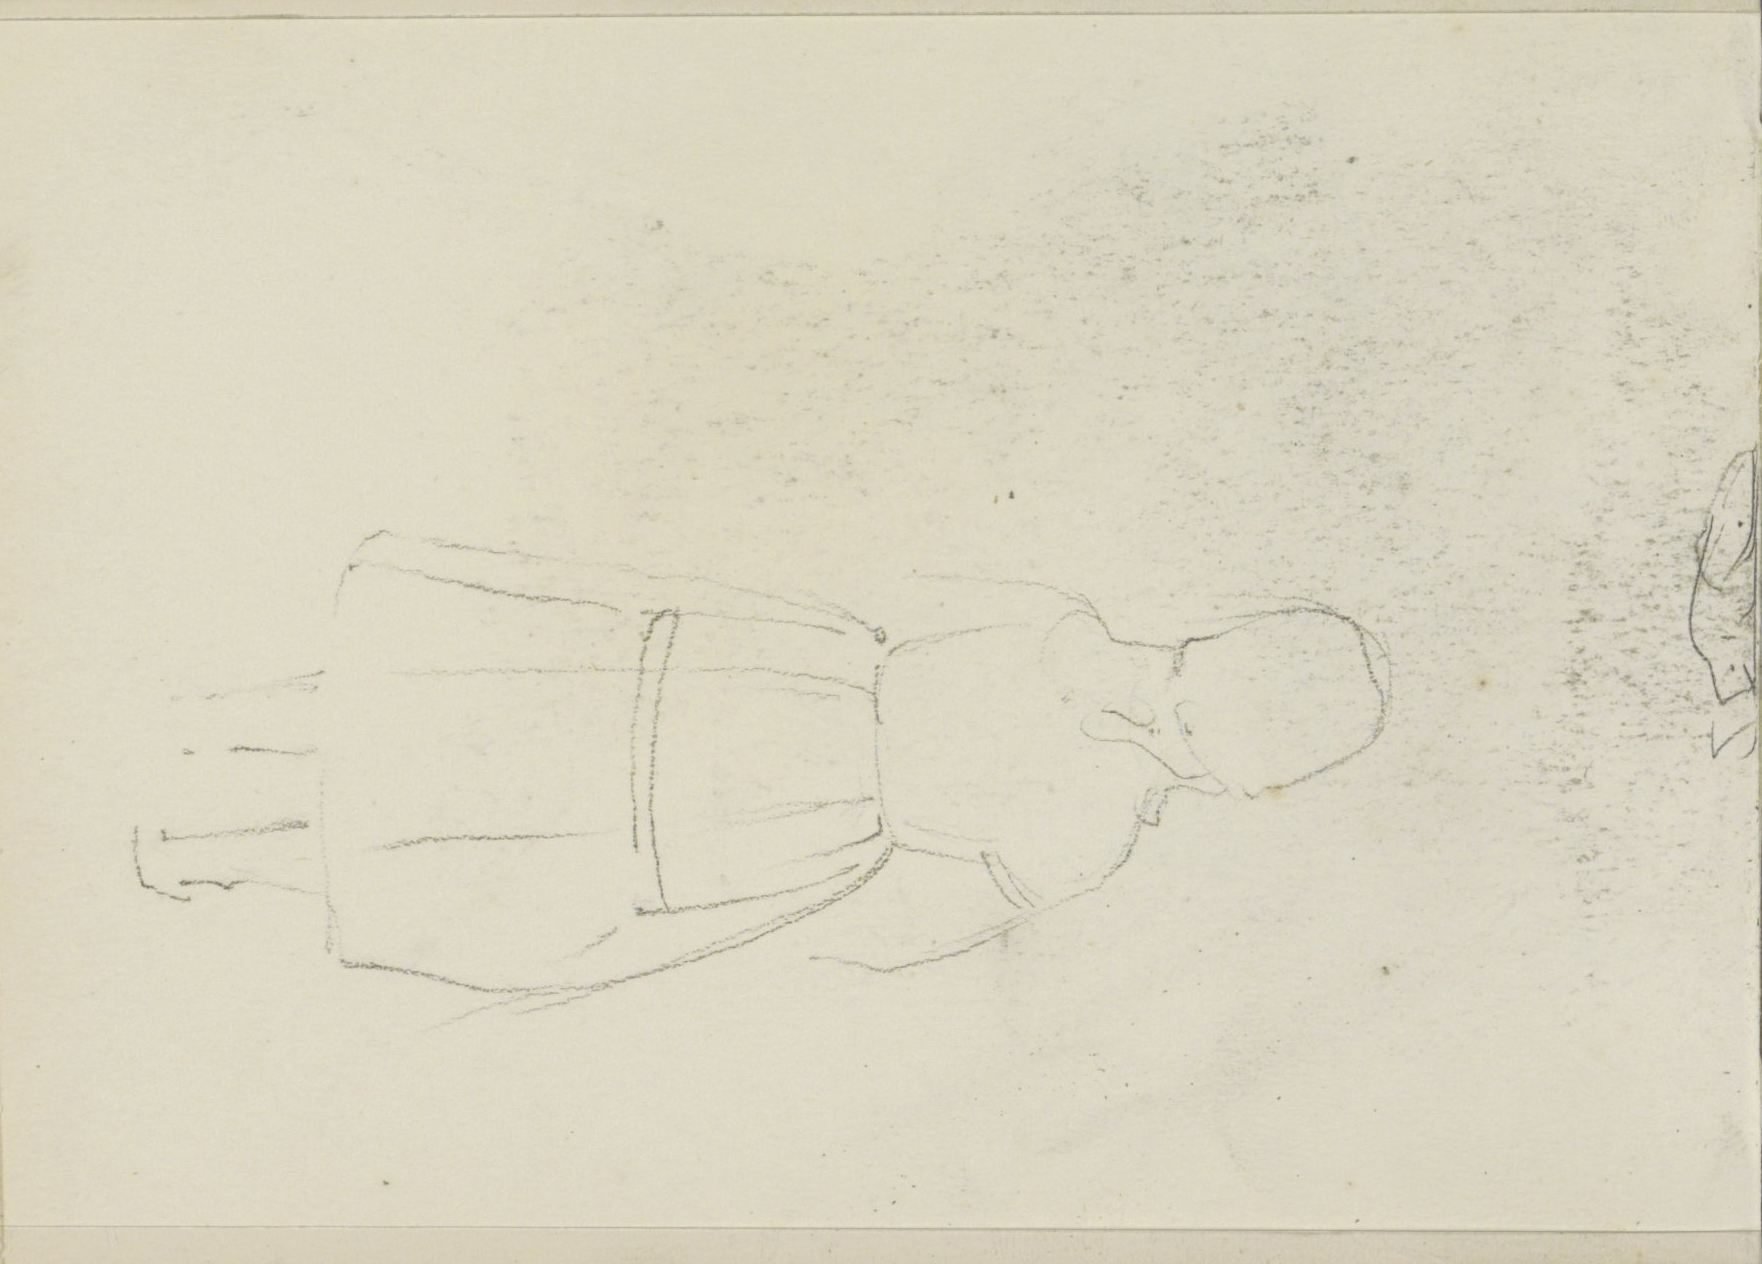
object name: sketchbook leaf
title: Meisje met een schort en kap, van achteren gezien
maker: a.a.l. de grammont-hubrecht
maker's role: draughtsman, painter, print maker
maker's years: 1855-1913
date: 1865-1913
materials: chalk, paper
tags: apron (+ girls' clothes), boy (child between toddler and youth)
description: Blad 15 verso uit een schetsboek met 38 bladen.